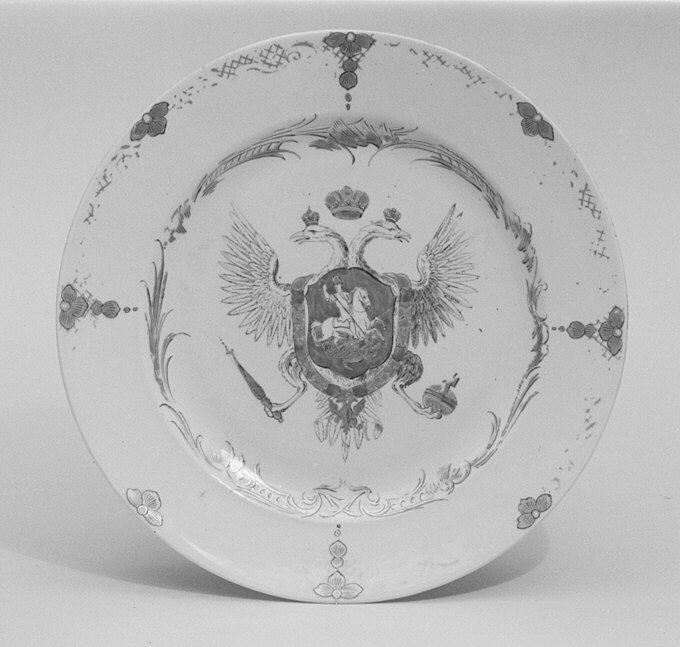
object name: dish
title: Dish (one of two)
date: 1775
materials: hard paste porcelain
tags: birds,horses,coat of arms